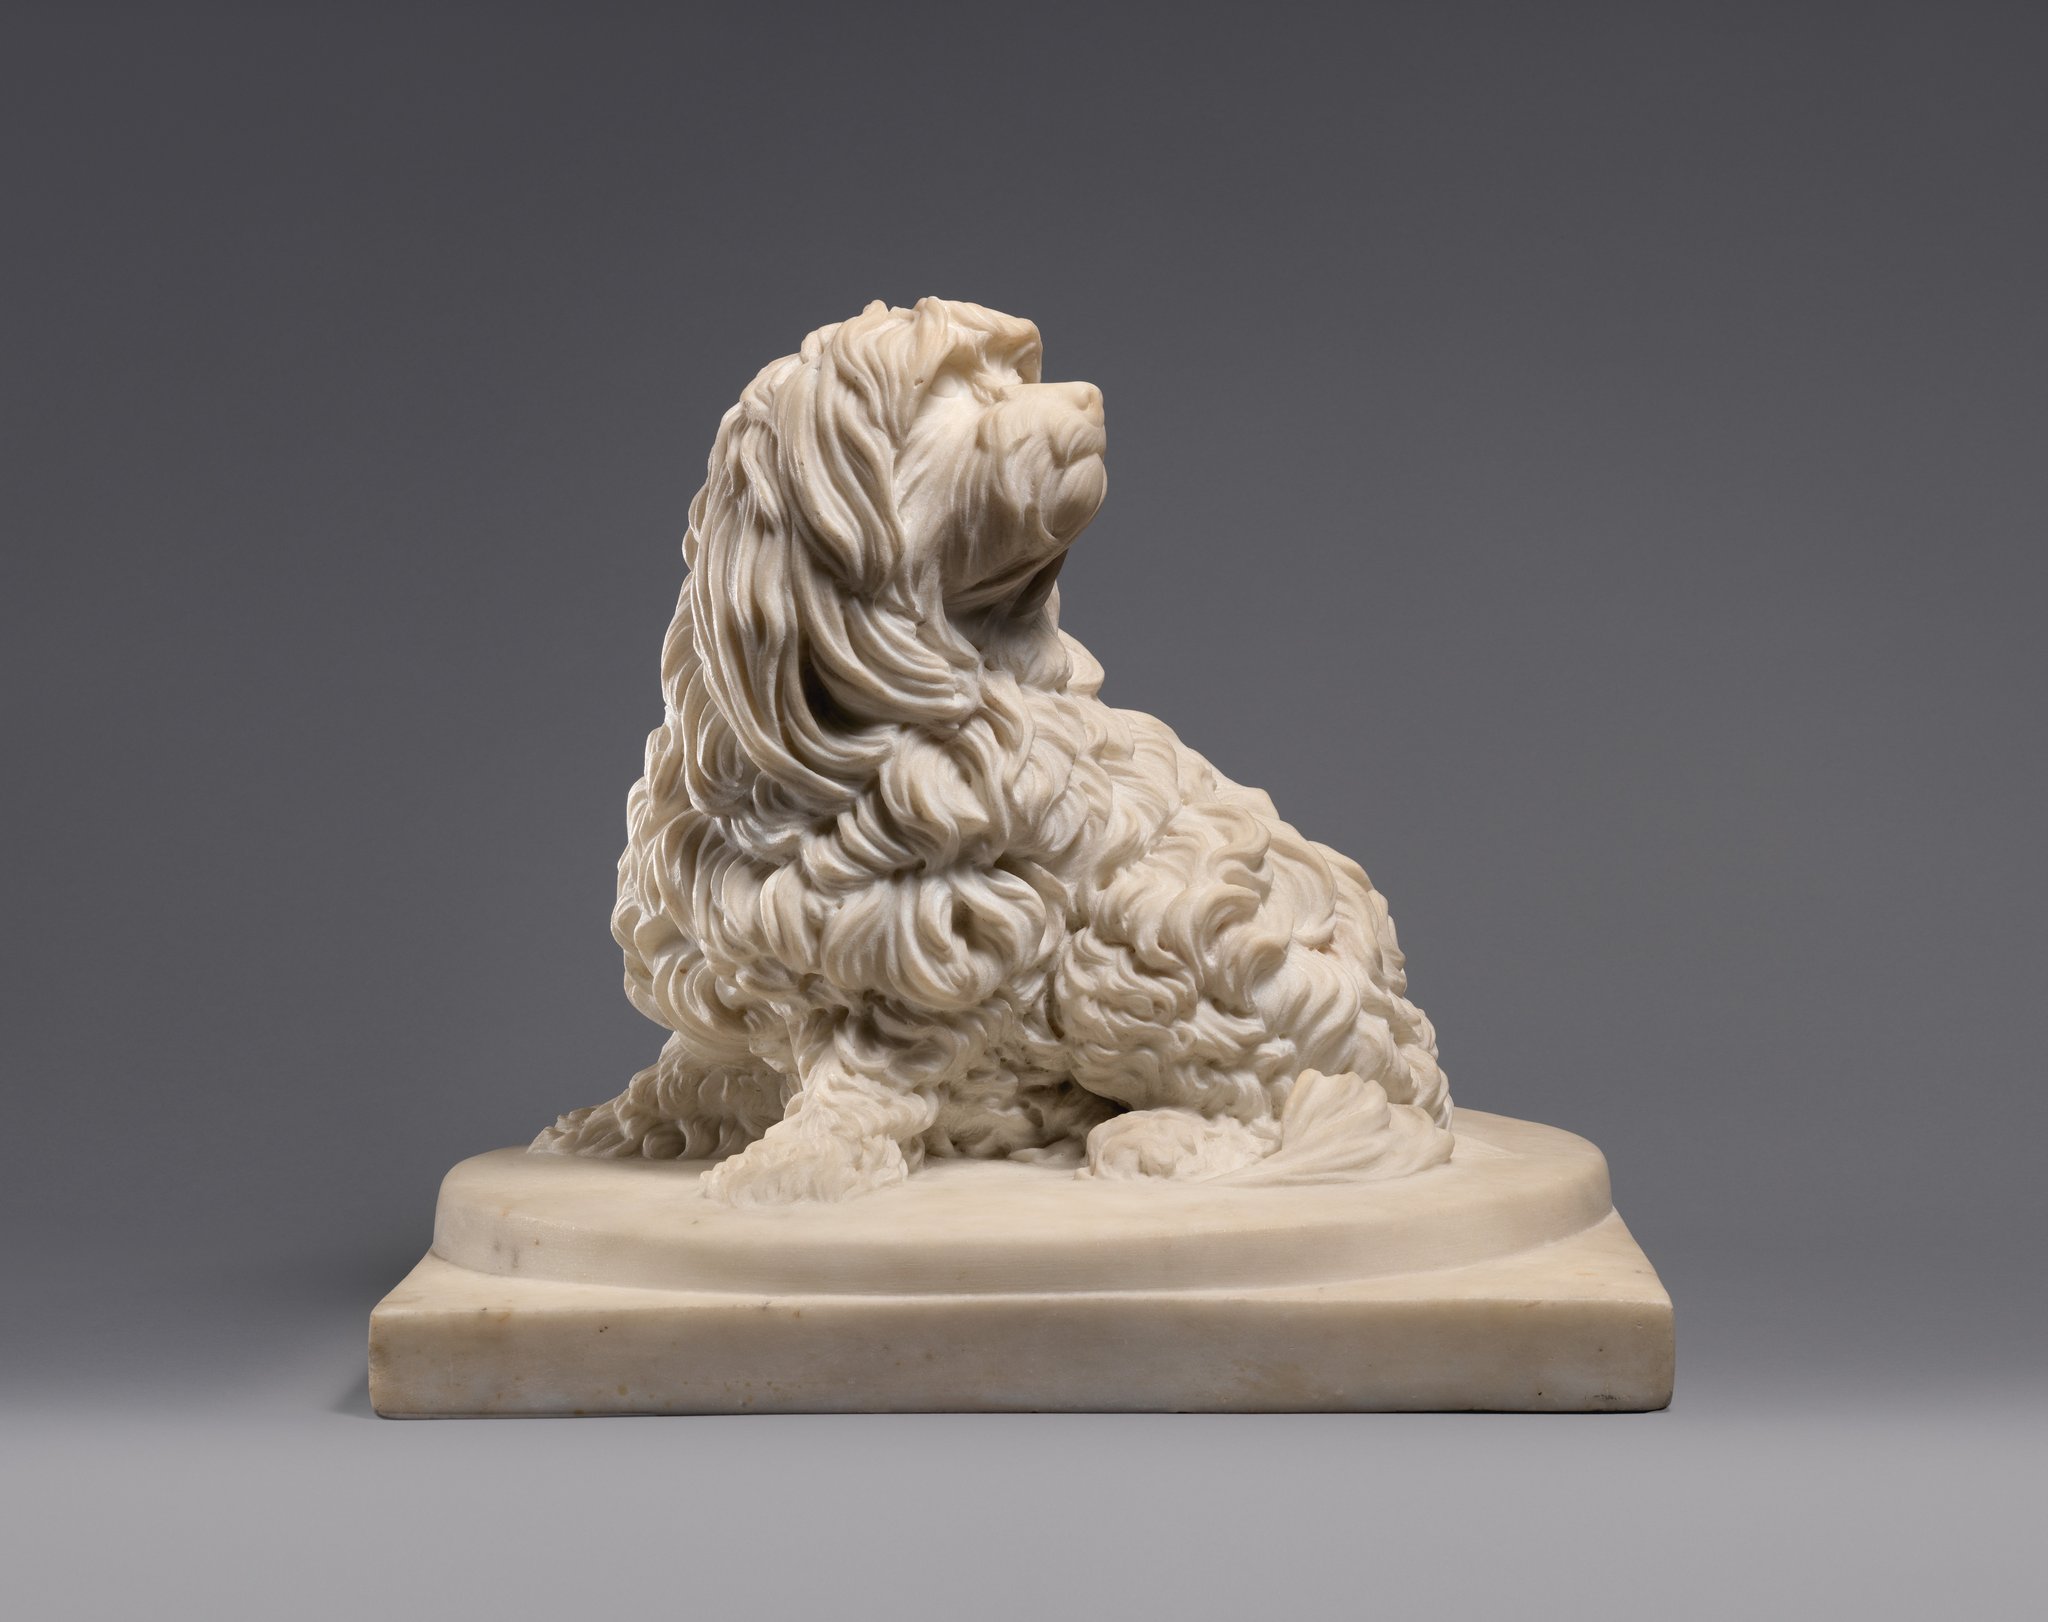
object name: figure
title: Shock Dog (nickname for a dog of the Maltese breed)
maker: anne seymour damer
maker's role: artist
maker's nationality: british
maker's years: 1748-1828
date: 1782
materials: marble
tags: dogs